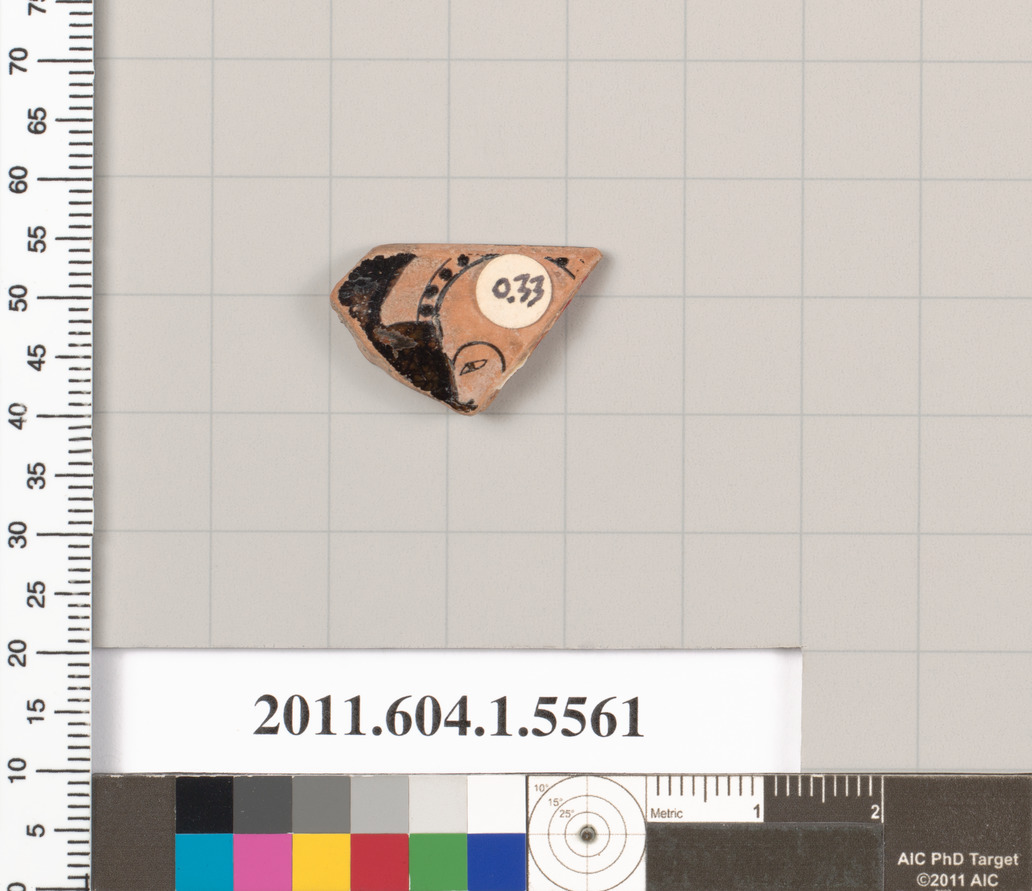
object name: kylix fragment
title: Terracotta rim fragment of a kylix (drinking cup)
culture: greek, attic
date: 520-510 BCE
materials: terracotta